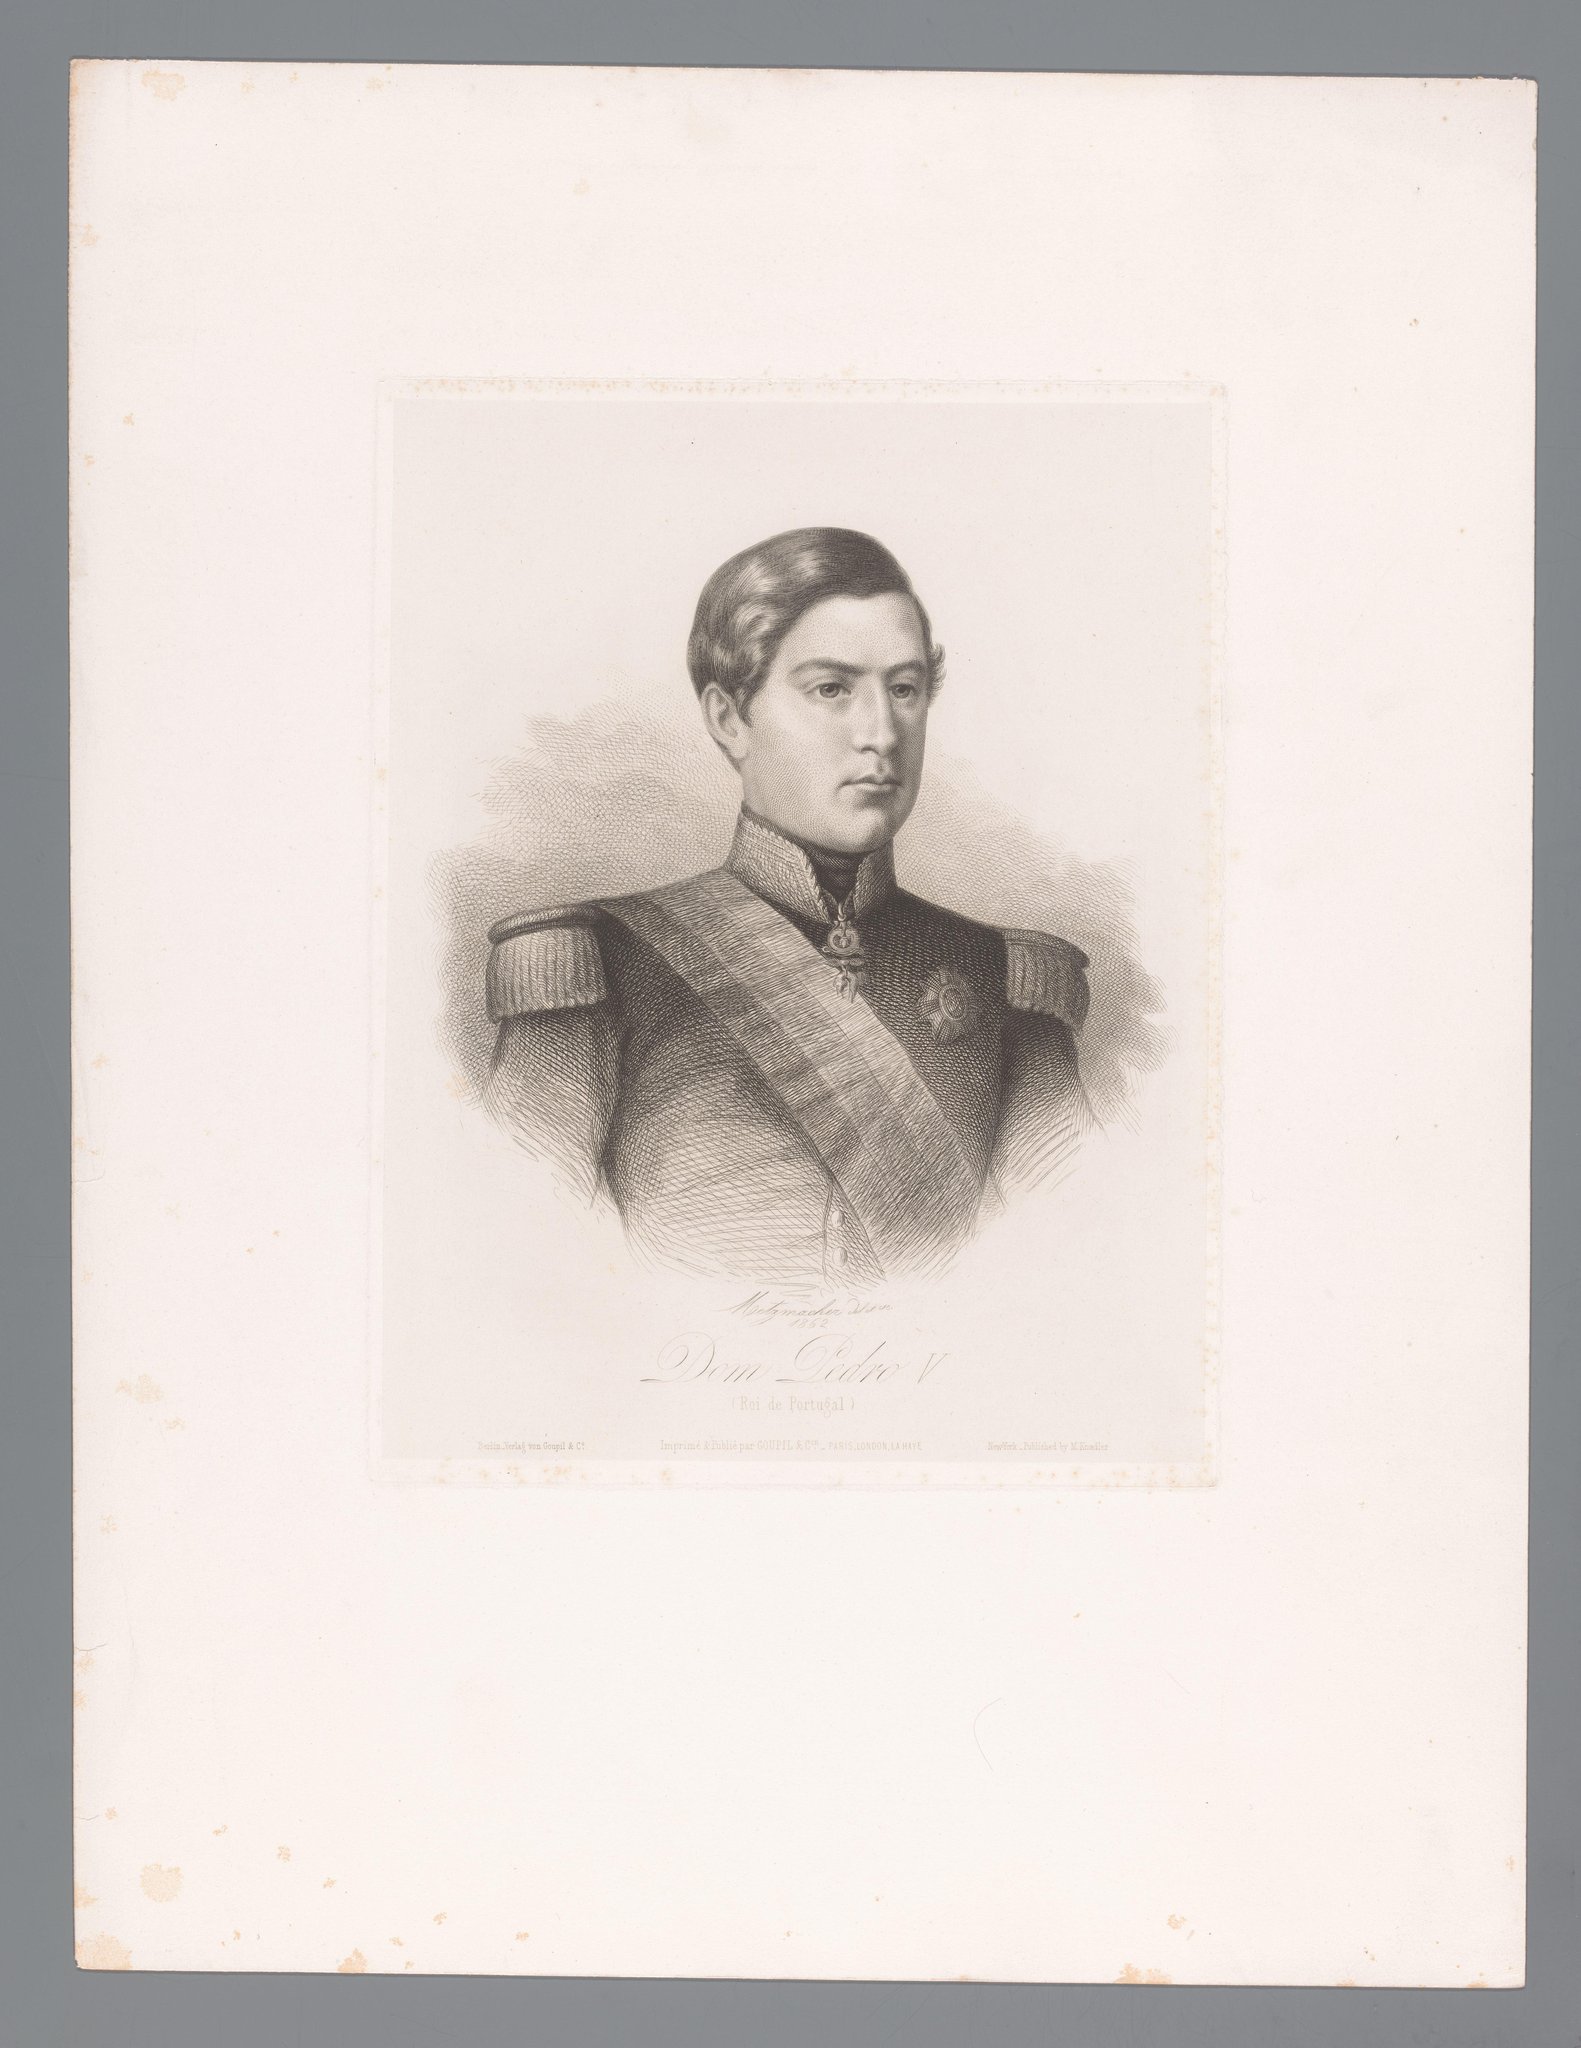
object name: print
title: Dom Pedro V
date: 1862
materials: paper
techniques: engraving, etching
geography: berlin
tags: historical persons, ruler, sovereign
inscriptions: collector's mark: Lugt 2228